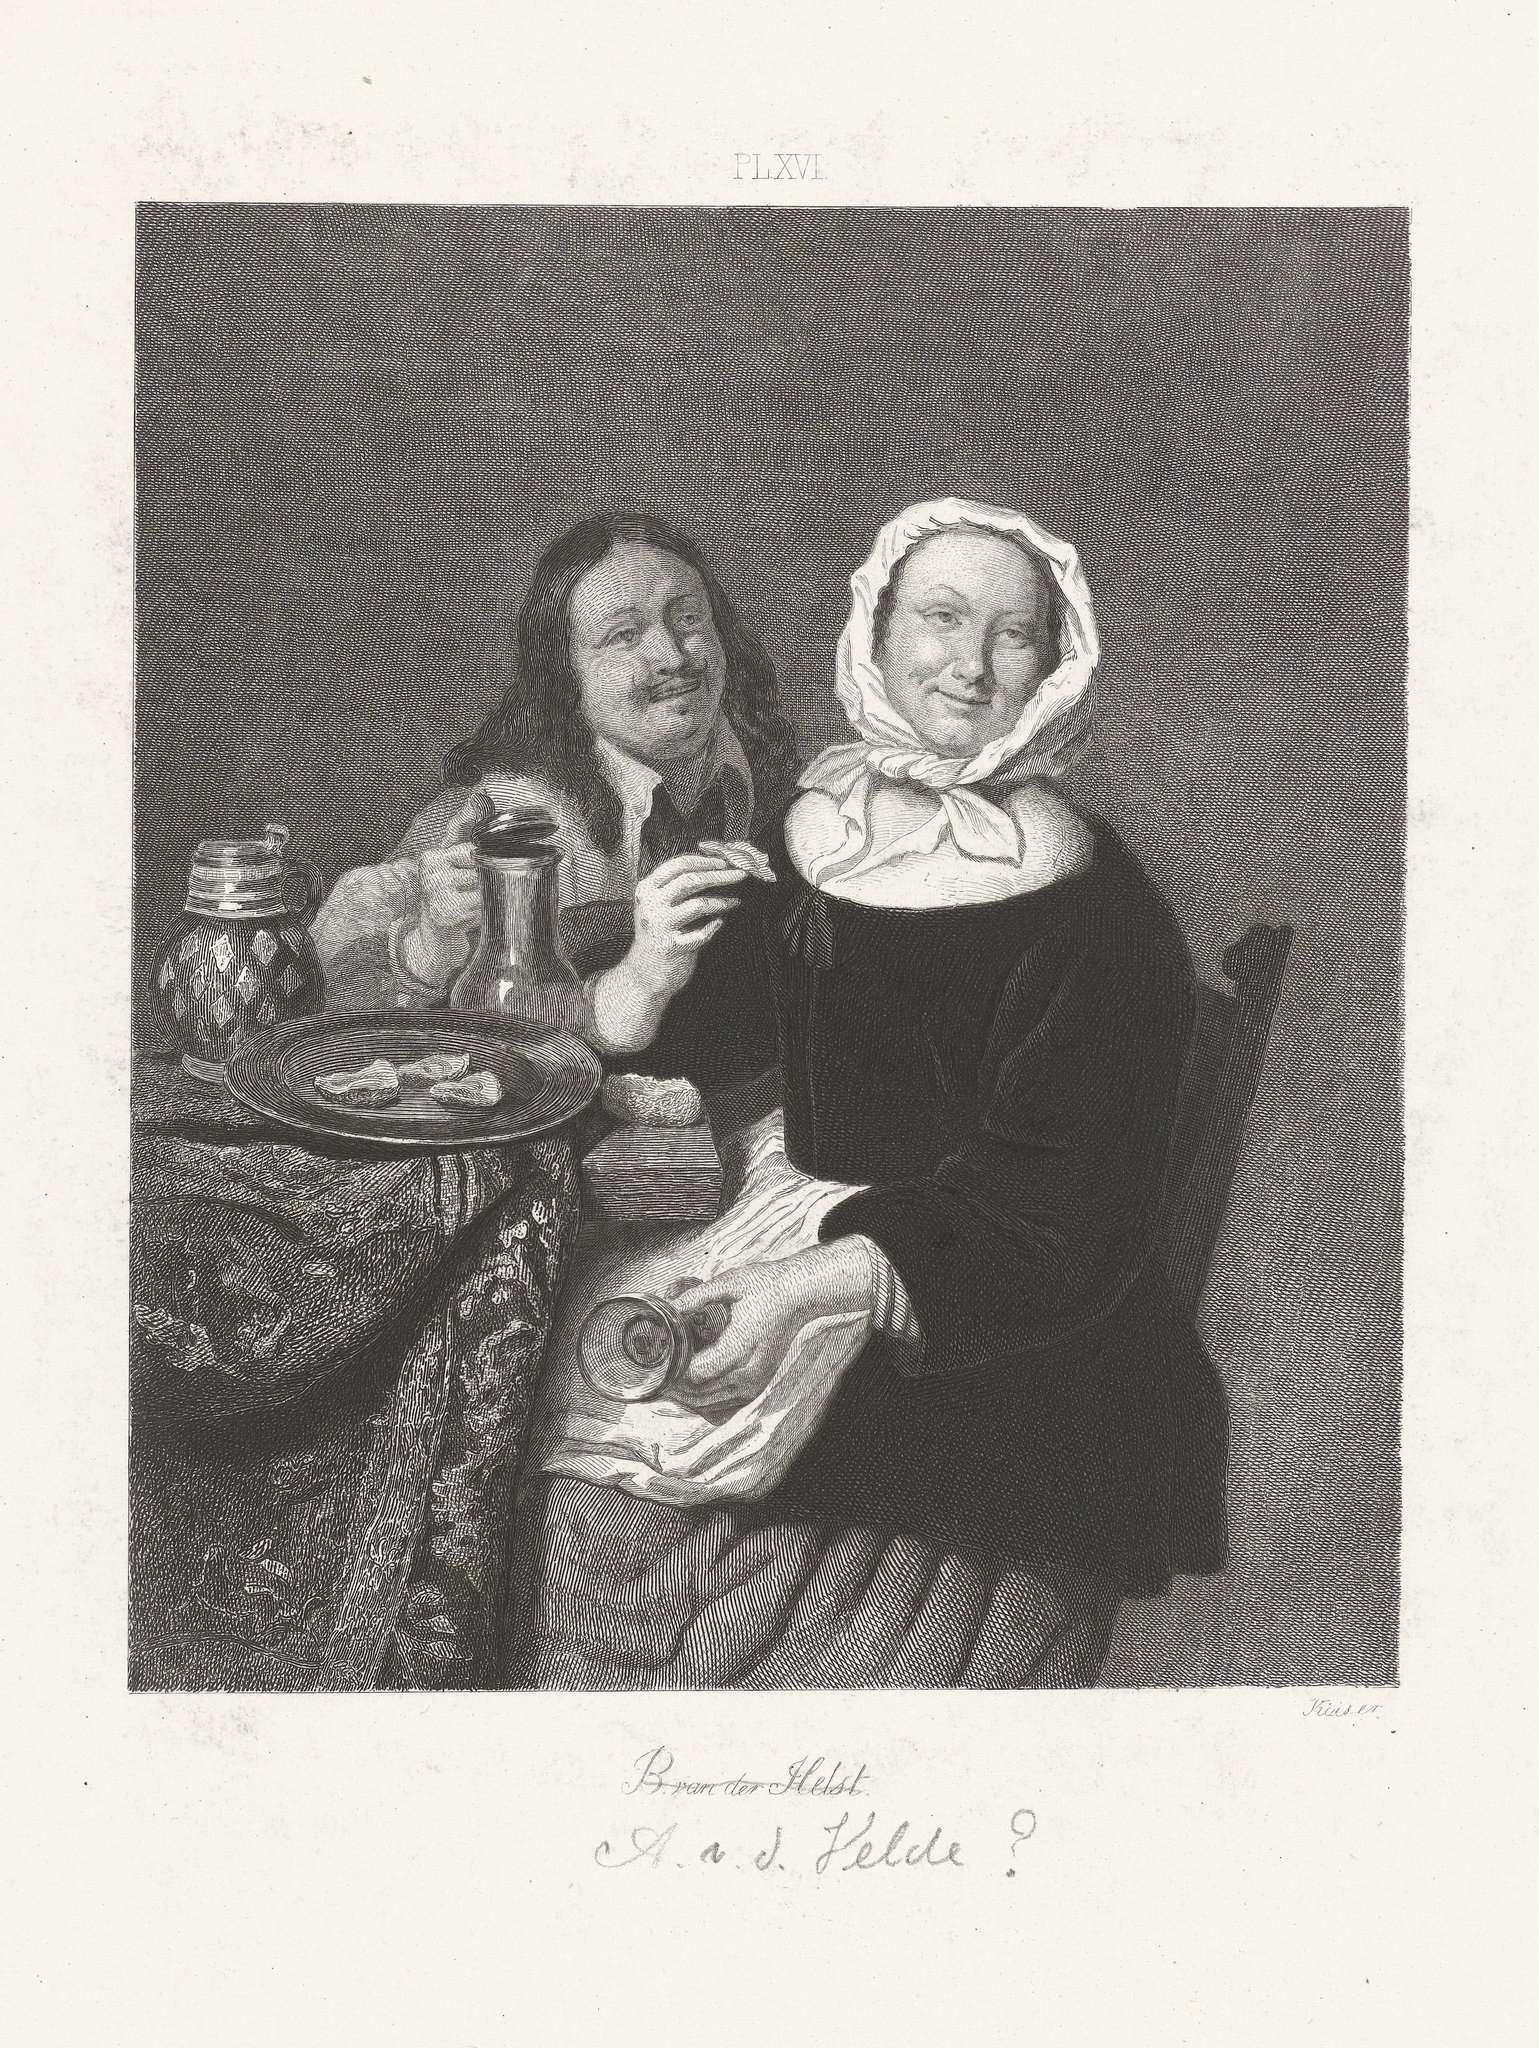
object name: print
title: Oestereters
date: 1823-1900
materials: paper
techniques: etching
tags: molluscs: oyster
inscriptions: collector's mark: Lugt 2228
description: Een oester etende man en vrouw aan een tafel. De man heeft een bierpul in zijn rechterhand en de vrouw zit op een stoel. Op de tafel staan een kruik en een bord met daarop drie oesters. De prent maakt deel uit van een serie van 25 prenten naar Hollandse meesters. Boven de afbeelding: PL XVI.